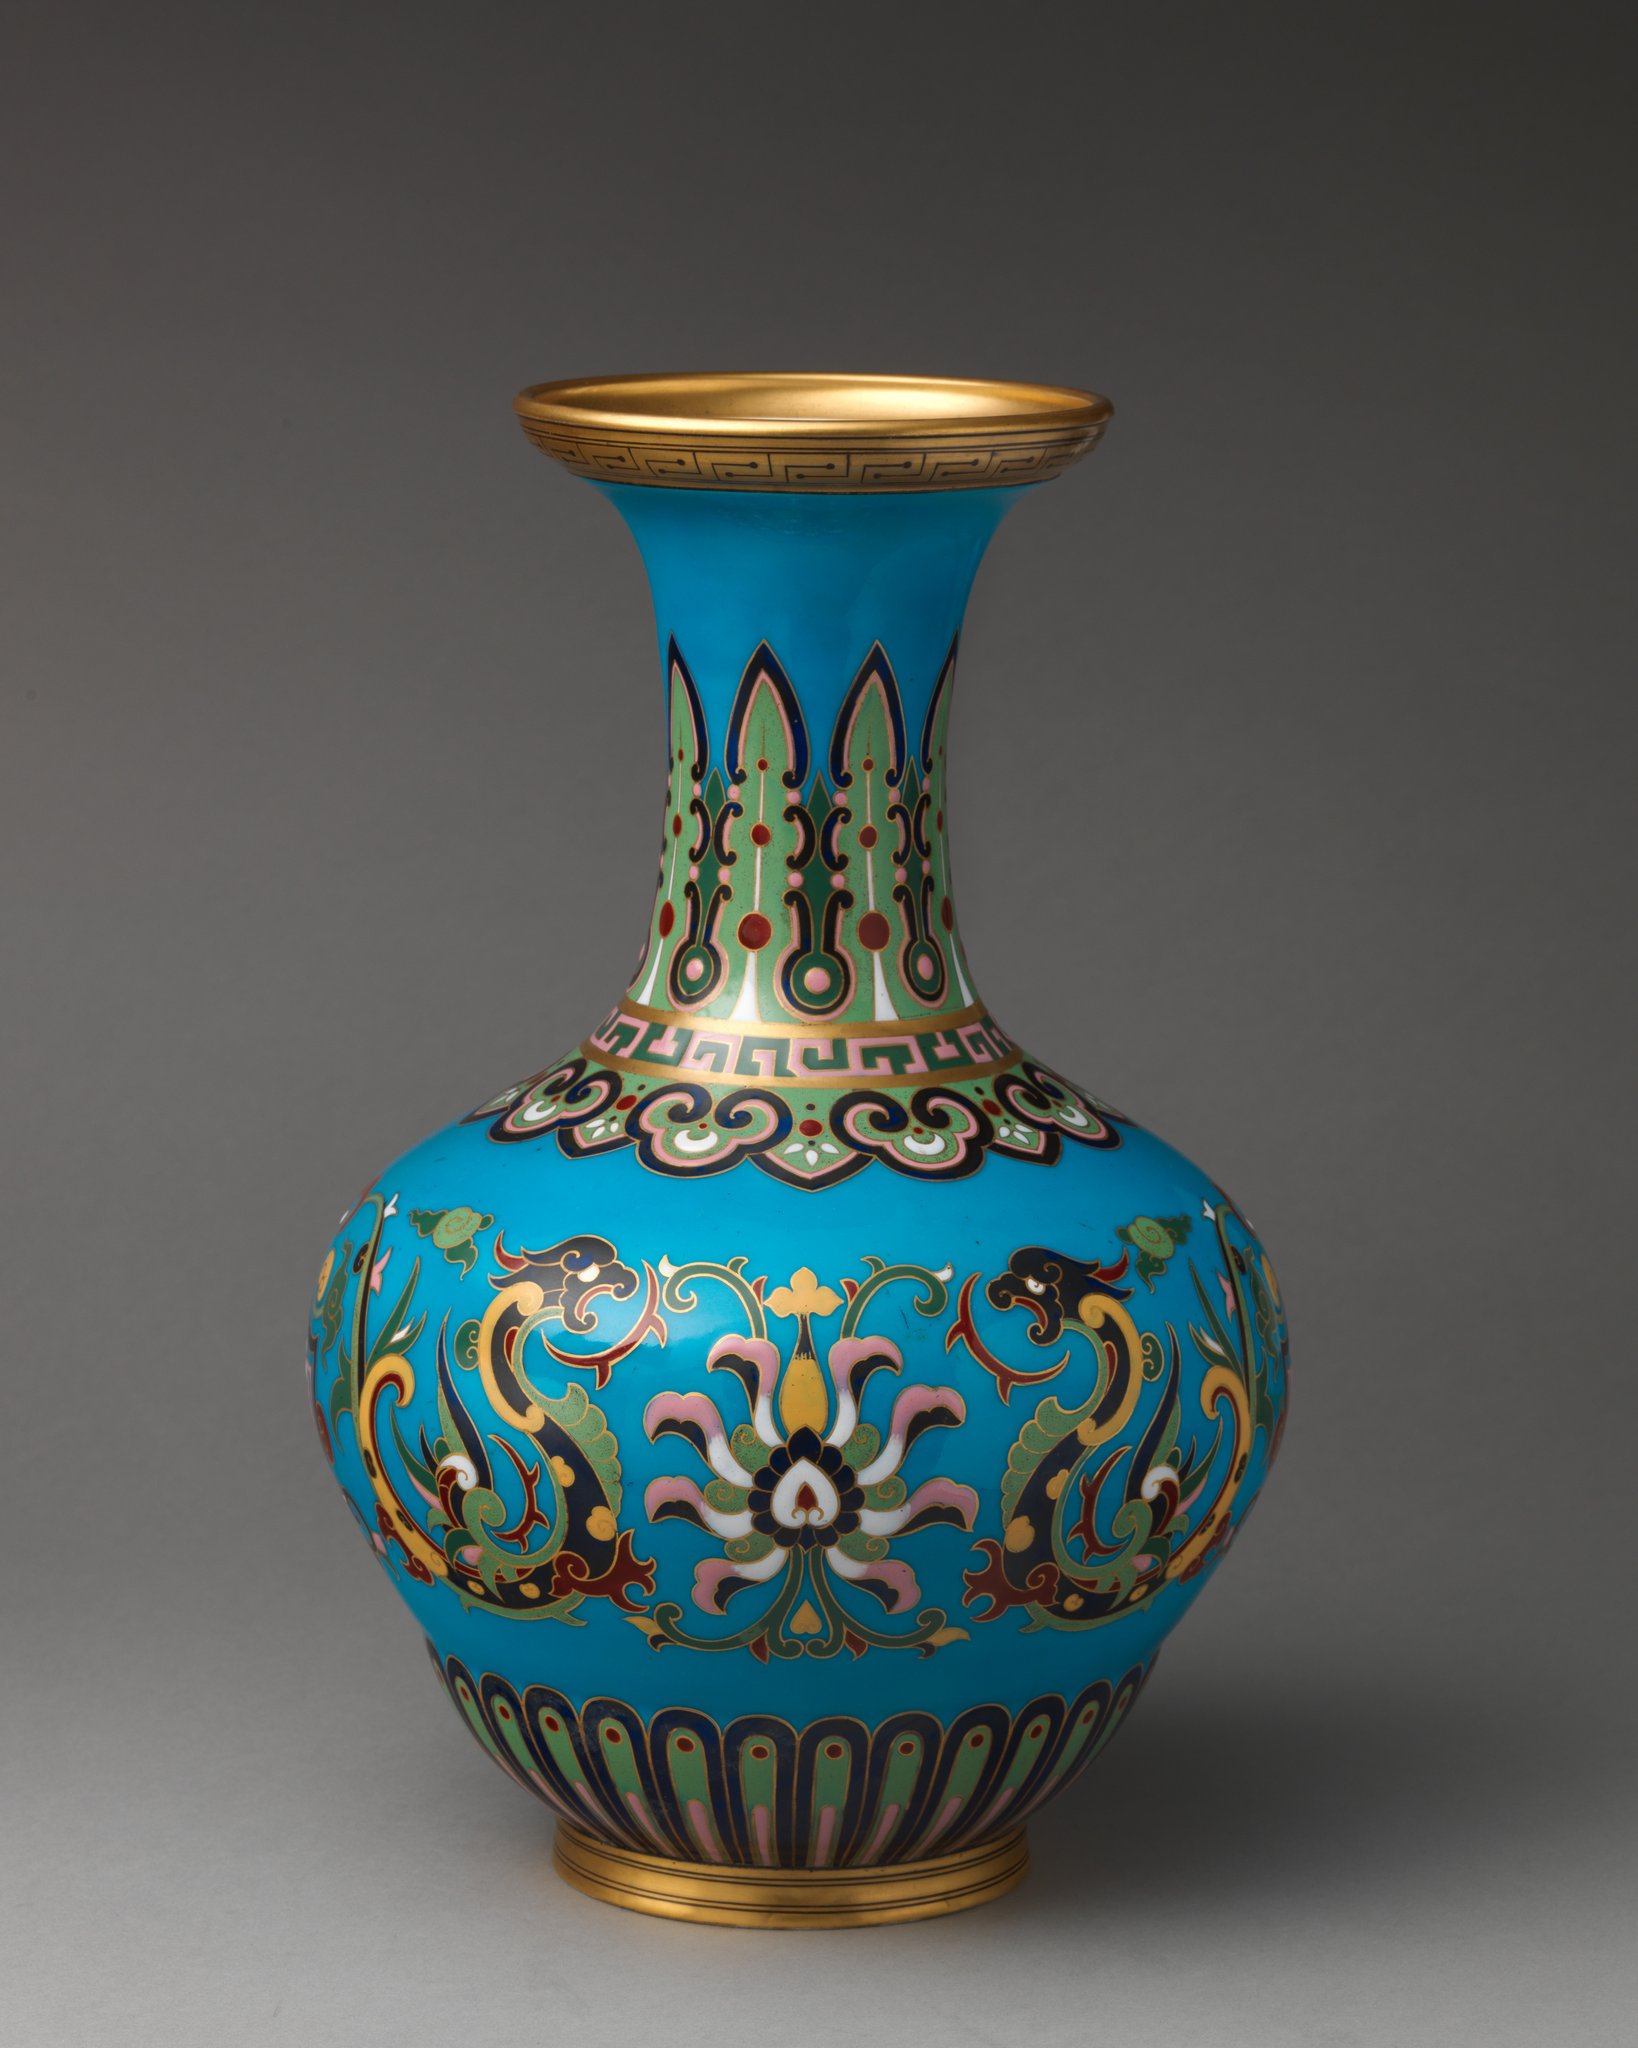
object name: vase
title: Vase with "cloisonné" decoration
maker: minton(s)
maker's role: maker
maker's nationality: british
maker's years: 1793-2001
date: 1870-1880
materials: bone china, enamel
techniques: gilding